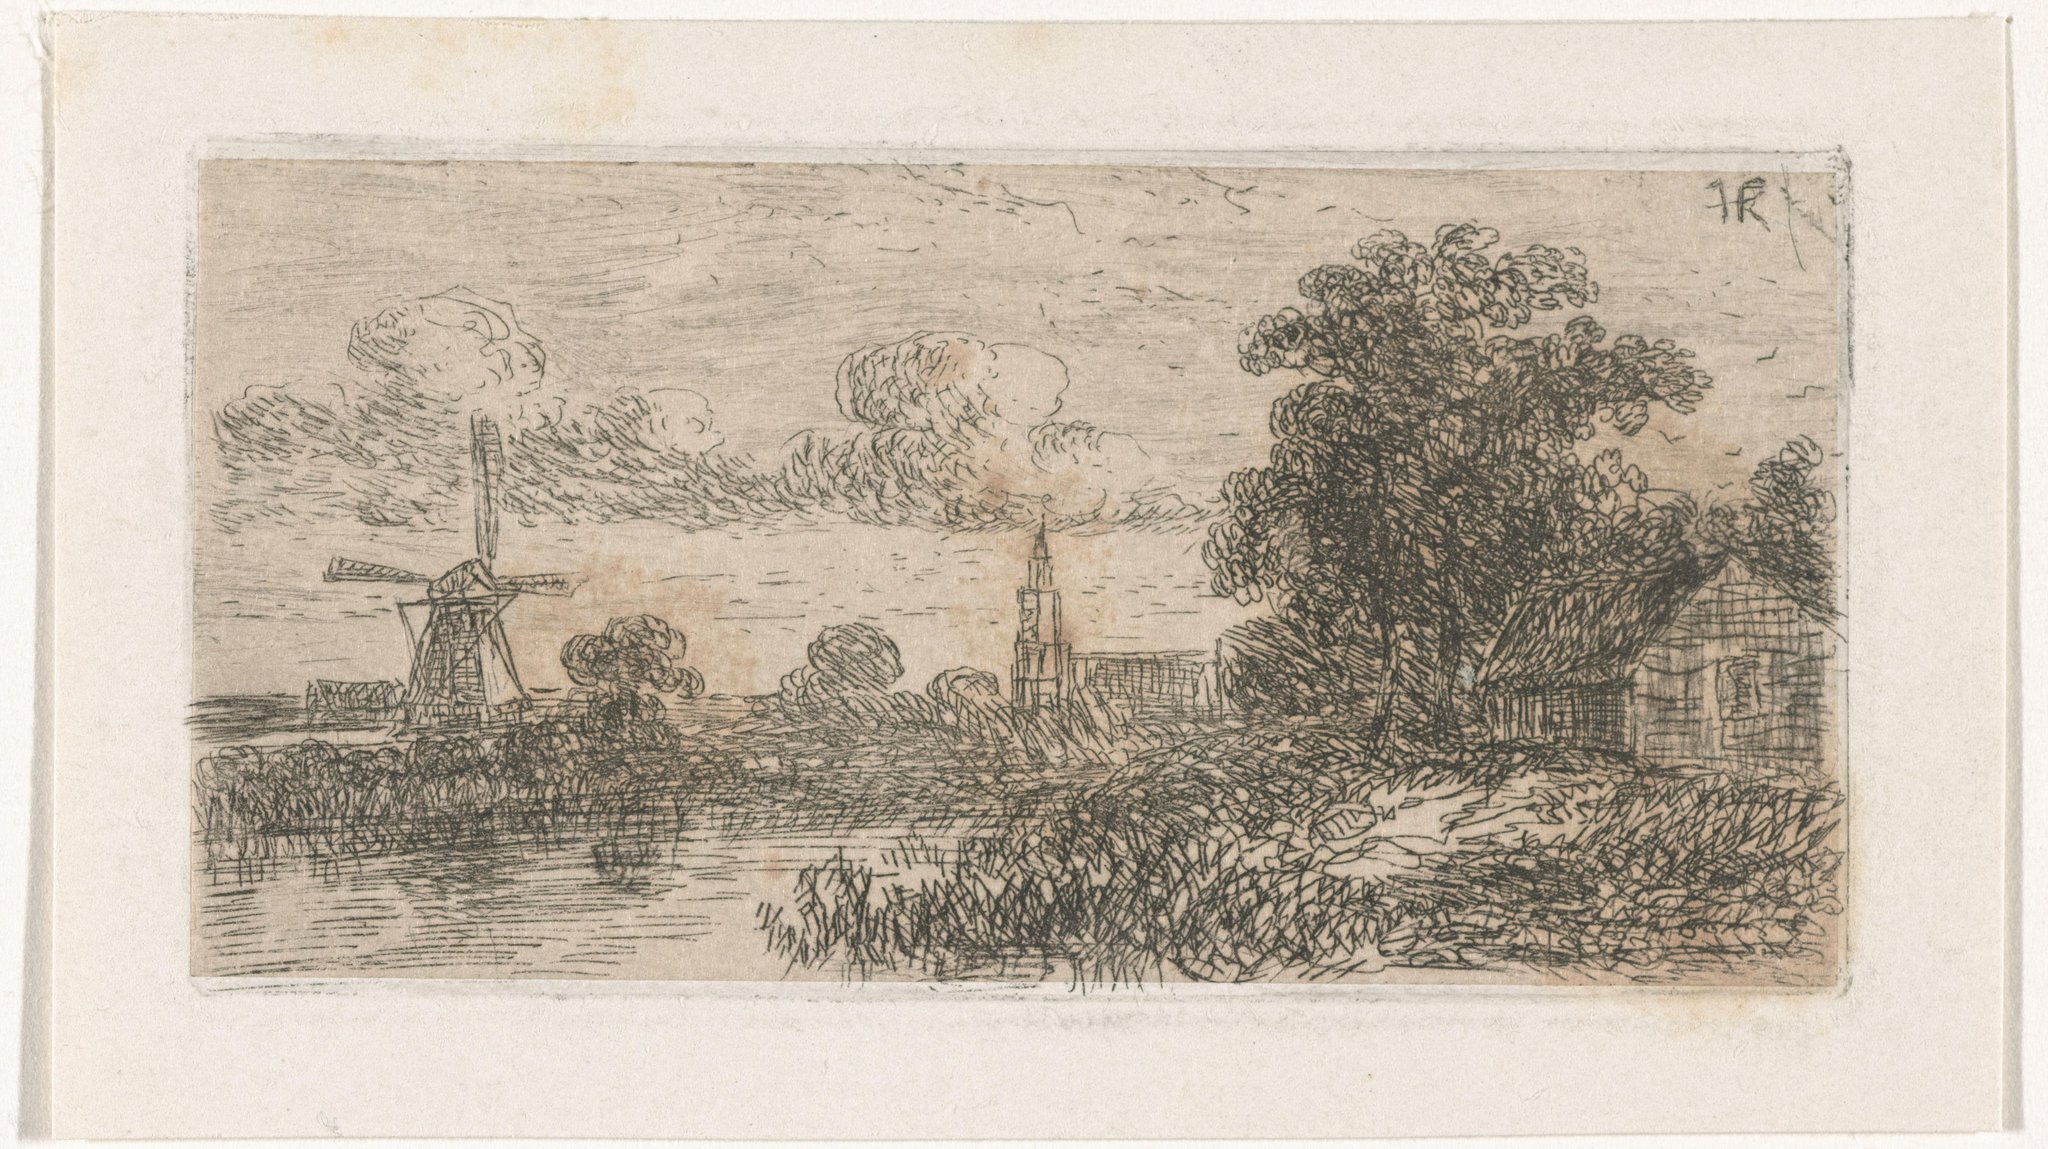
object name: print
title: Landschap met molen en kerk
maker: hermanus jan hendrik van rijkelijkhuysen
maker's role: painter, print maker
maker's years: 1813-1883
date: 1823-1883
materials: paper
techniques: etching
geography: utrecht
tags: river, church (exterior), windmill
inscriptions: collector's mark: Lugt 2228, collector's mark: Lugt 1484